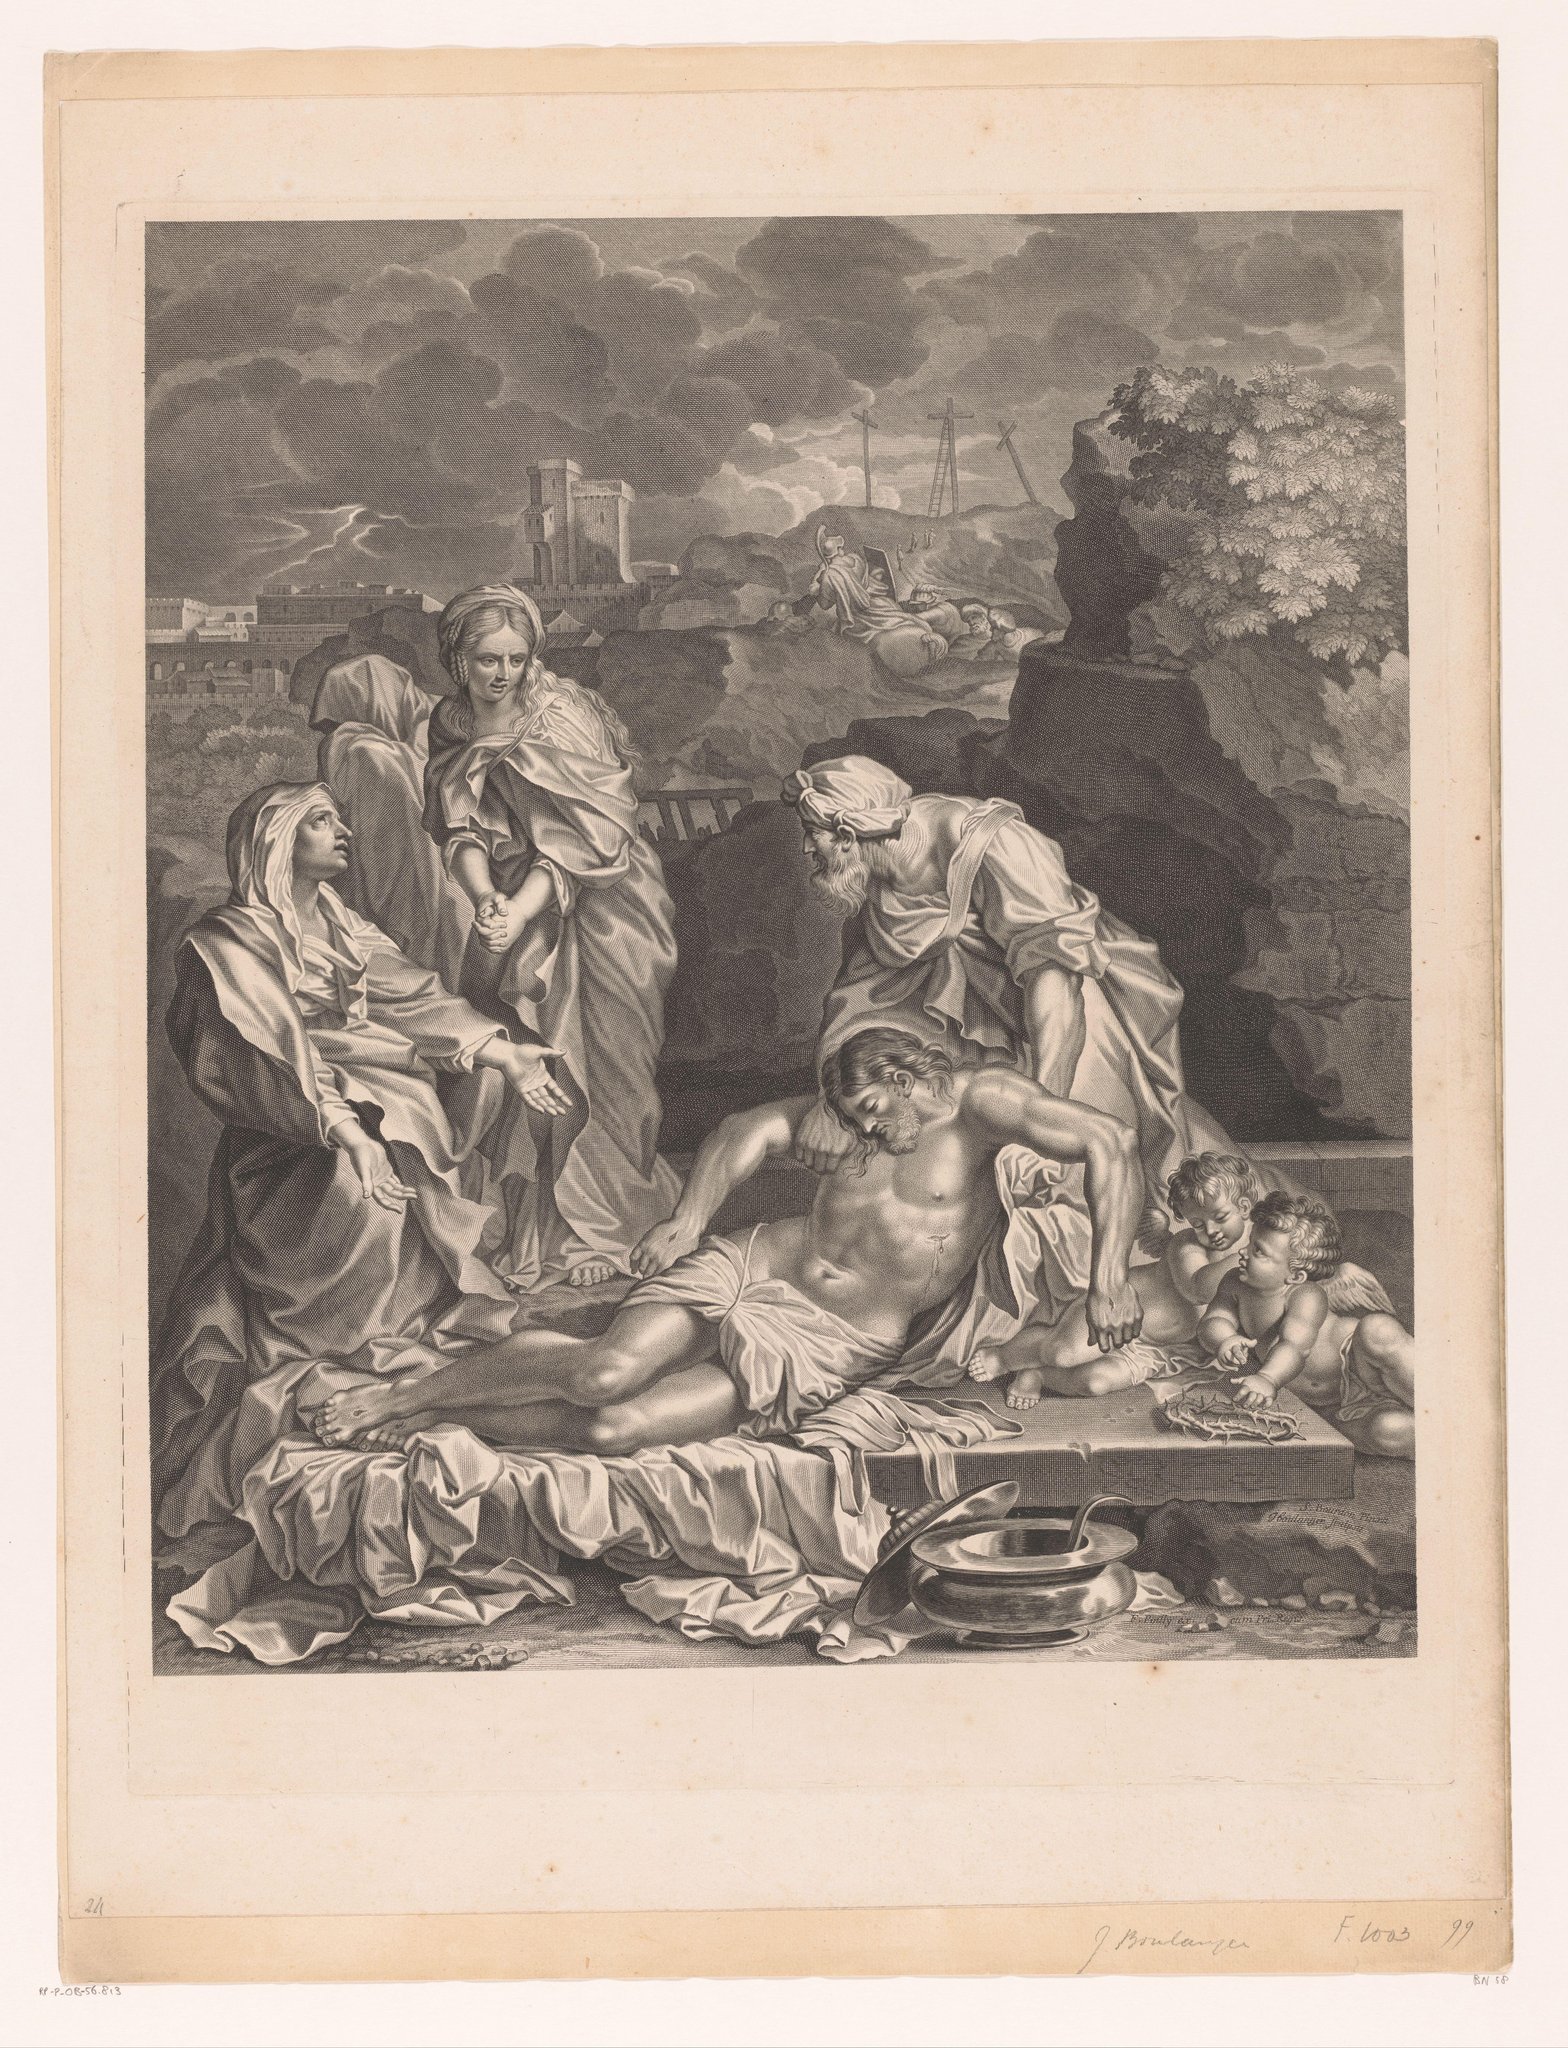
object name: print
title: Bewening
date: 1670-1680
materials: paper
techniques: engraving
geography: france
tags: lamentation over the dead christ by his relatives and friends (christ usually without crown of thorns)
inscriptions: collector's mark: Lugt 240